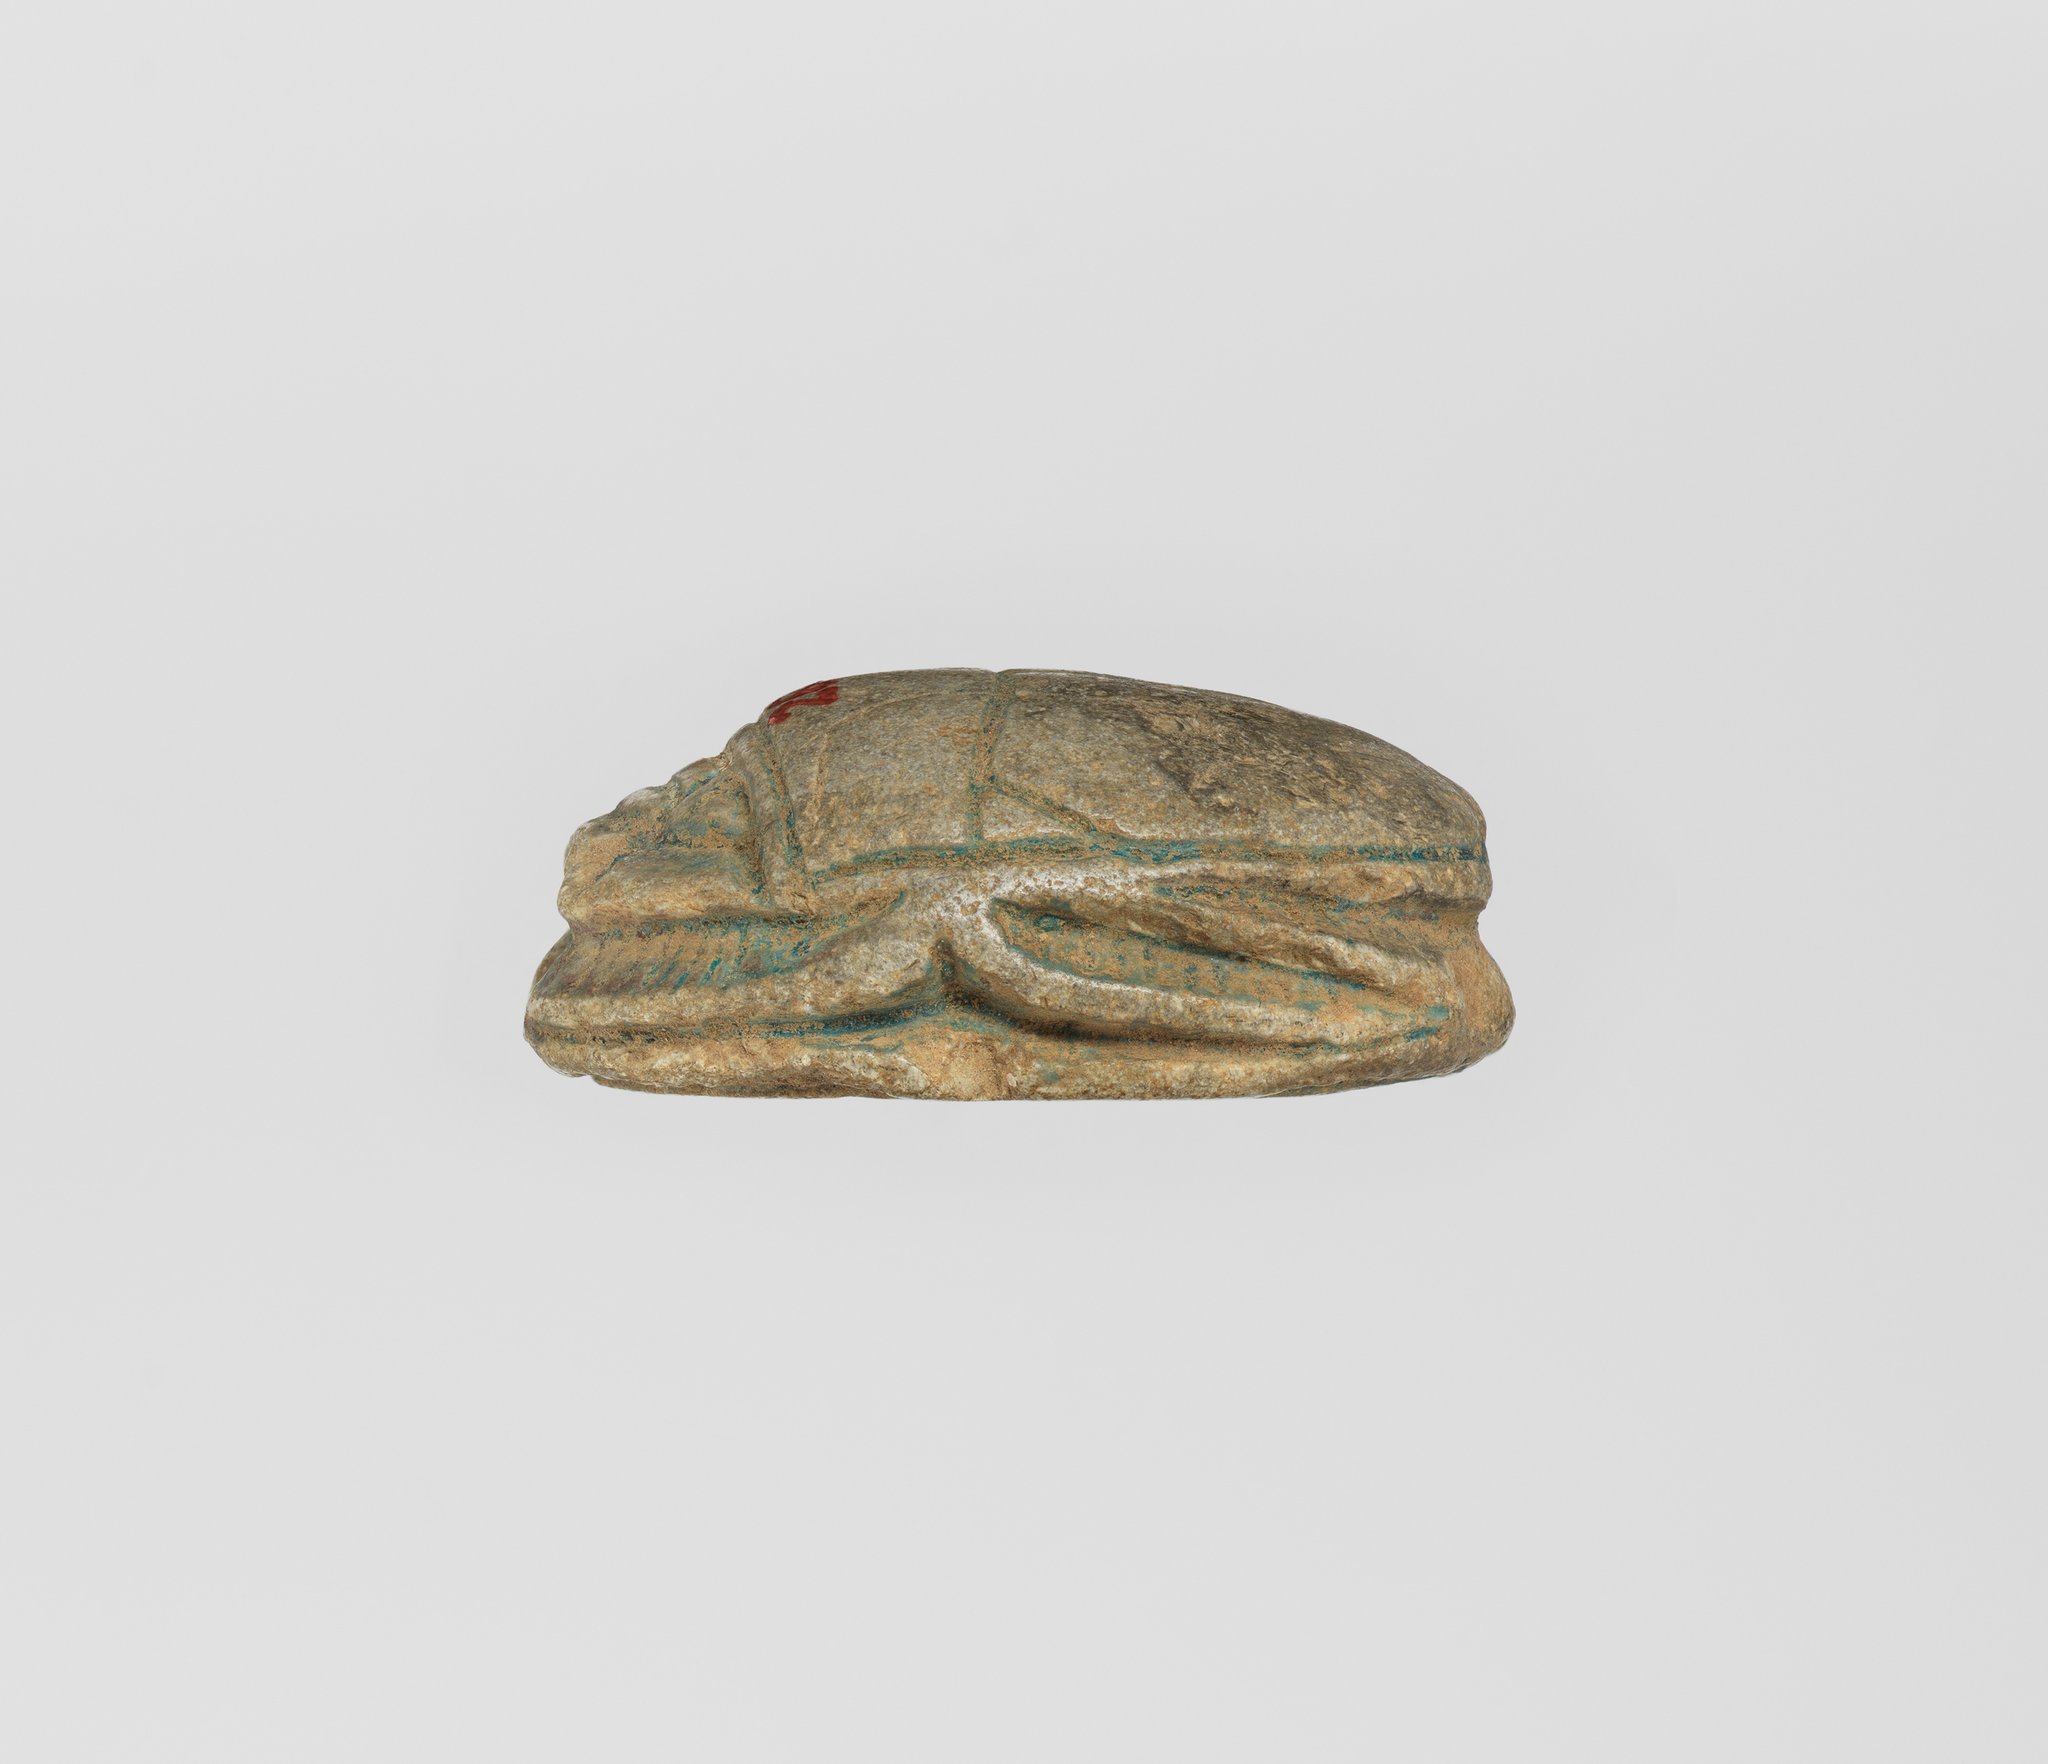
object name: scarab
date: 750-300 BCE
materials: stone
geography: nubia